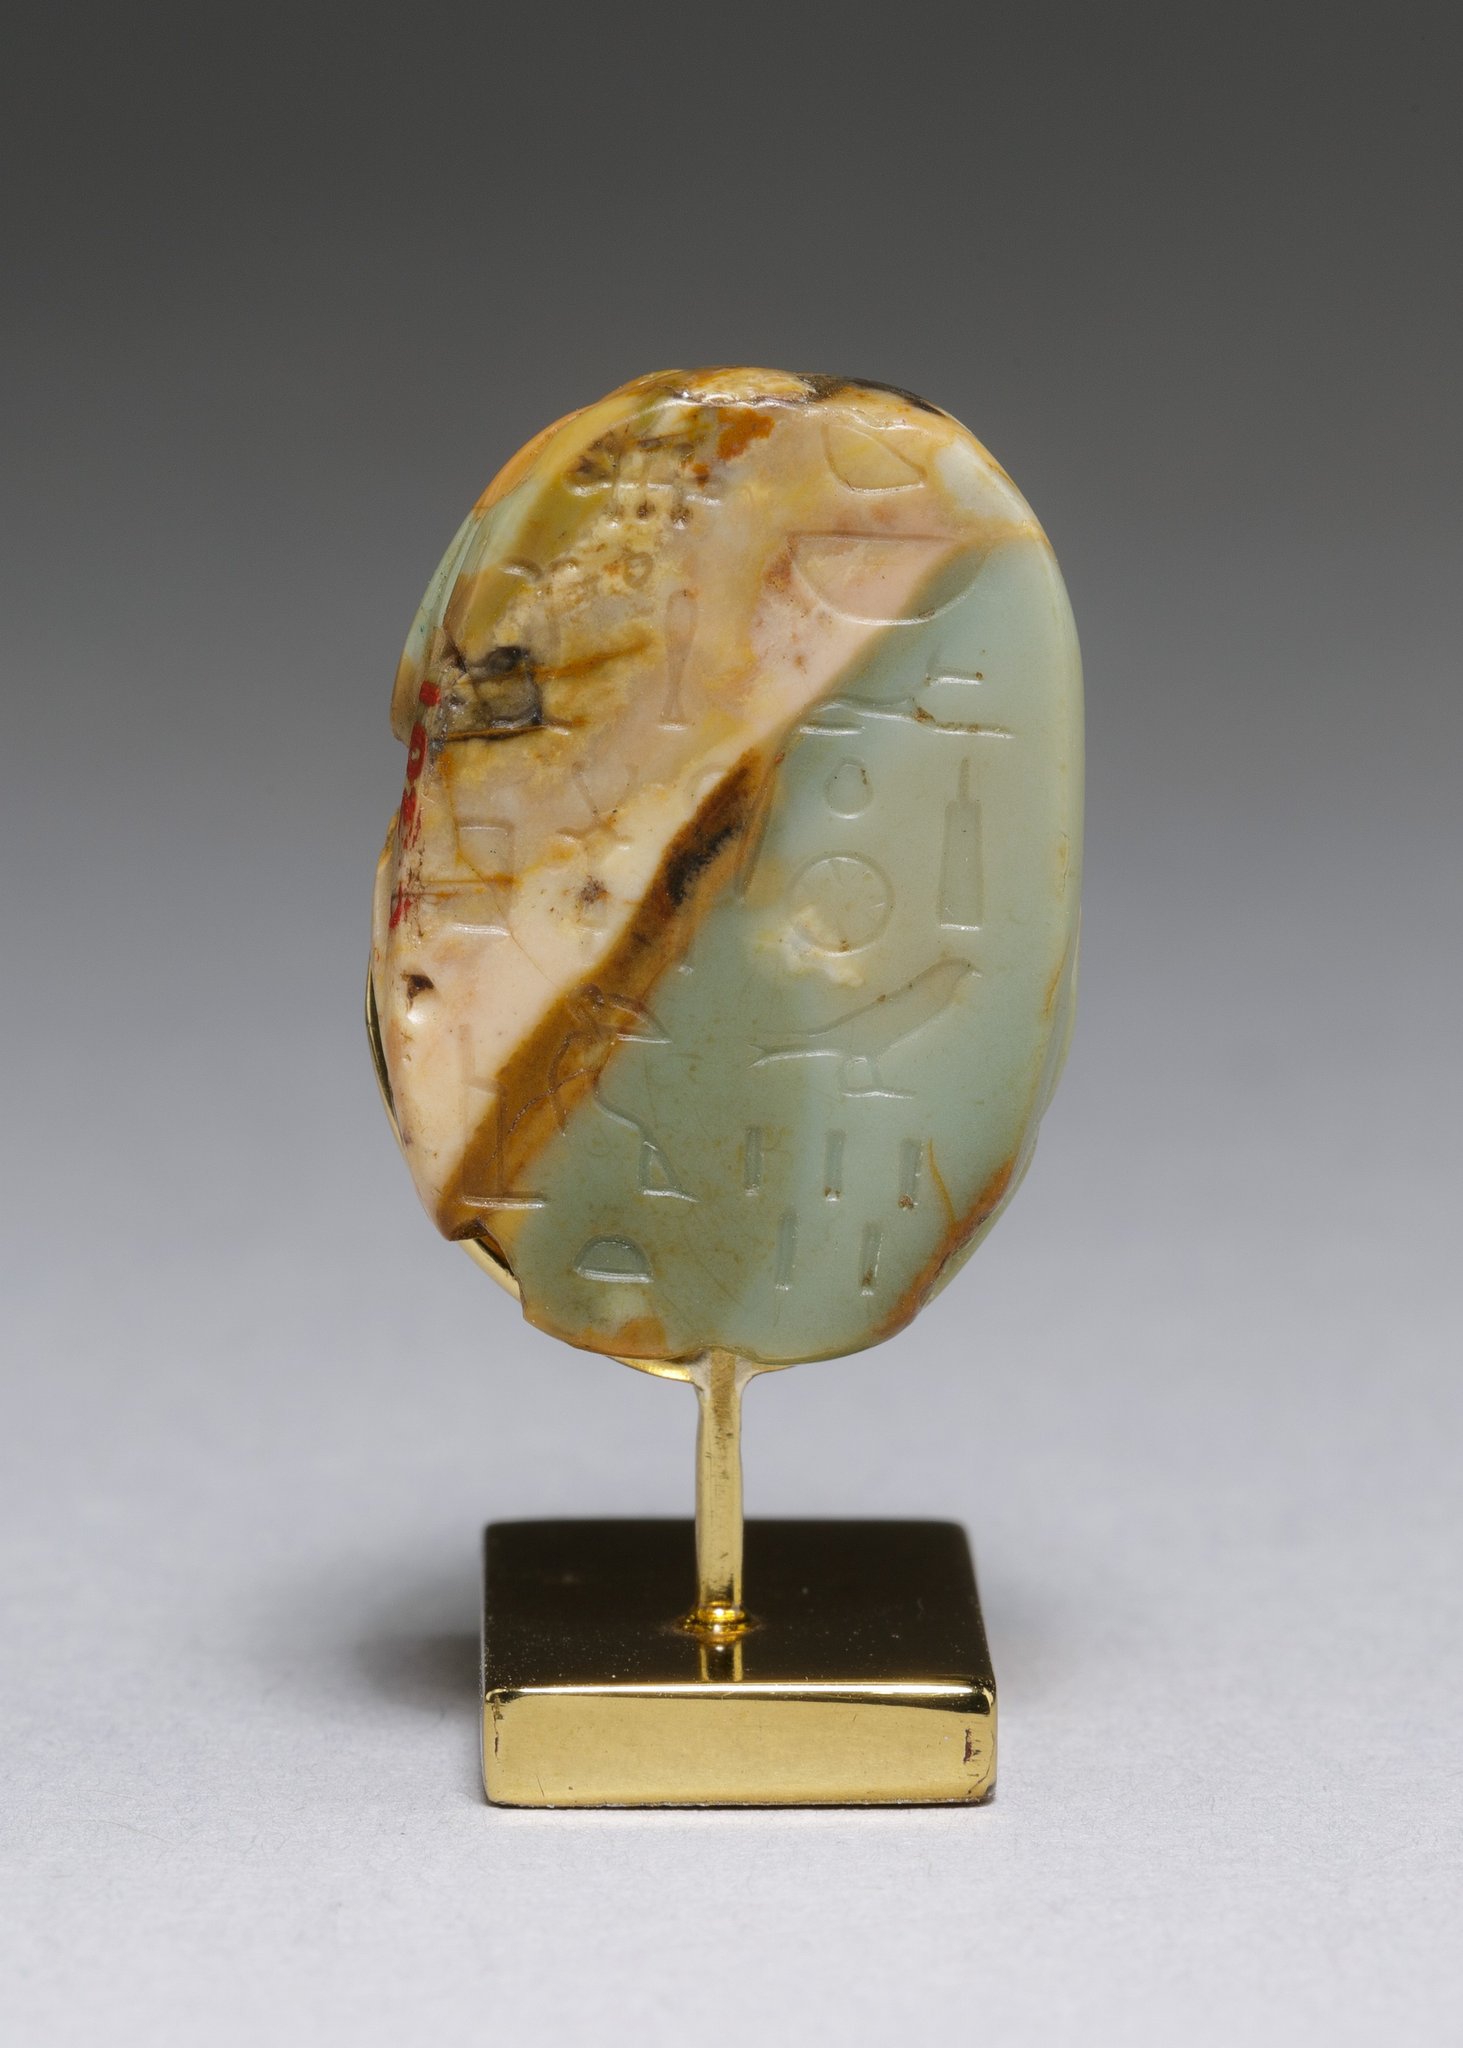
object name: scarab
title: Scarab of Pacherediset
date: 664-525 BCE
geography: egypt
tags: hieroglyphs,scarabs